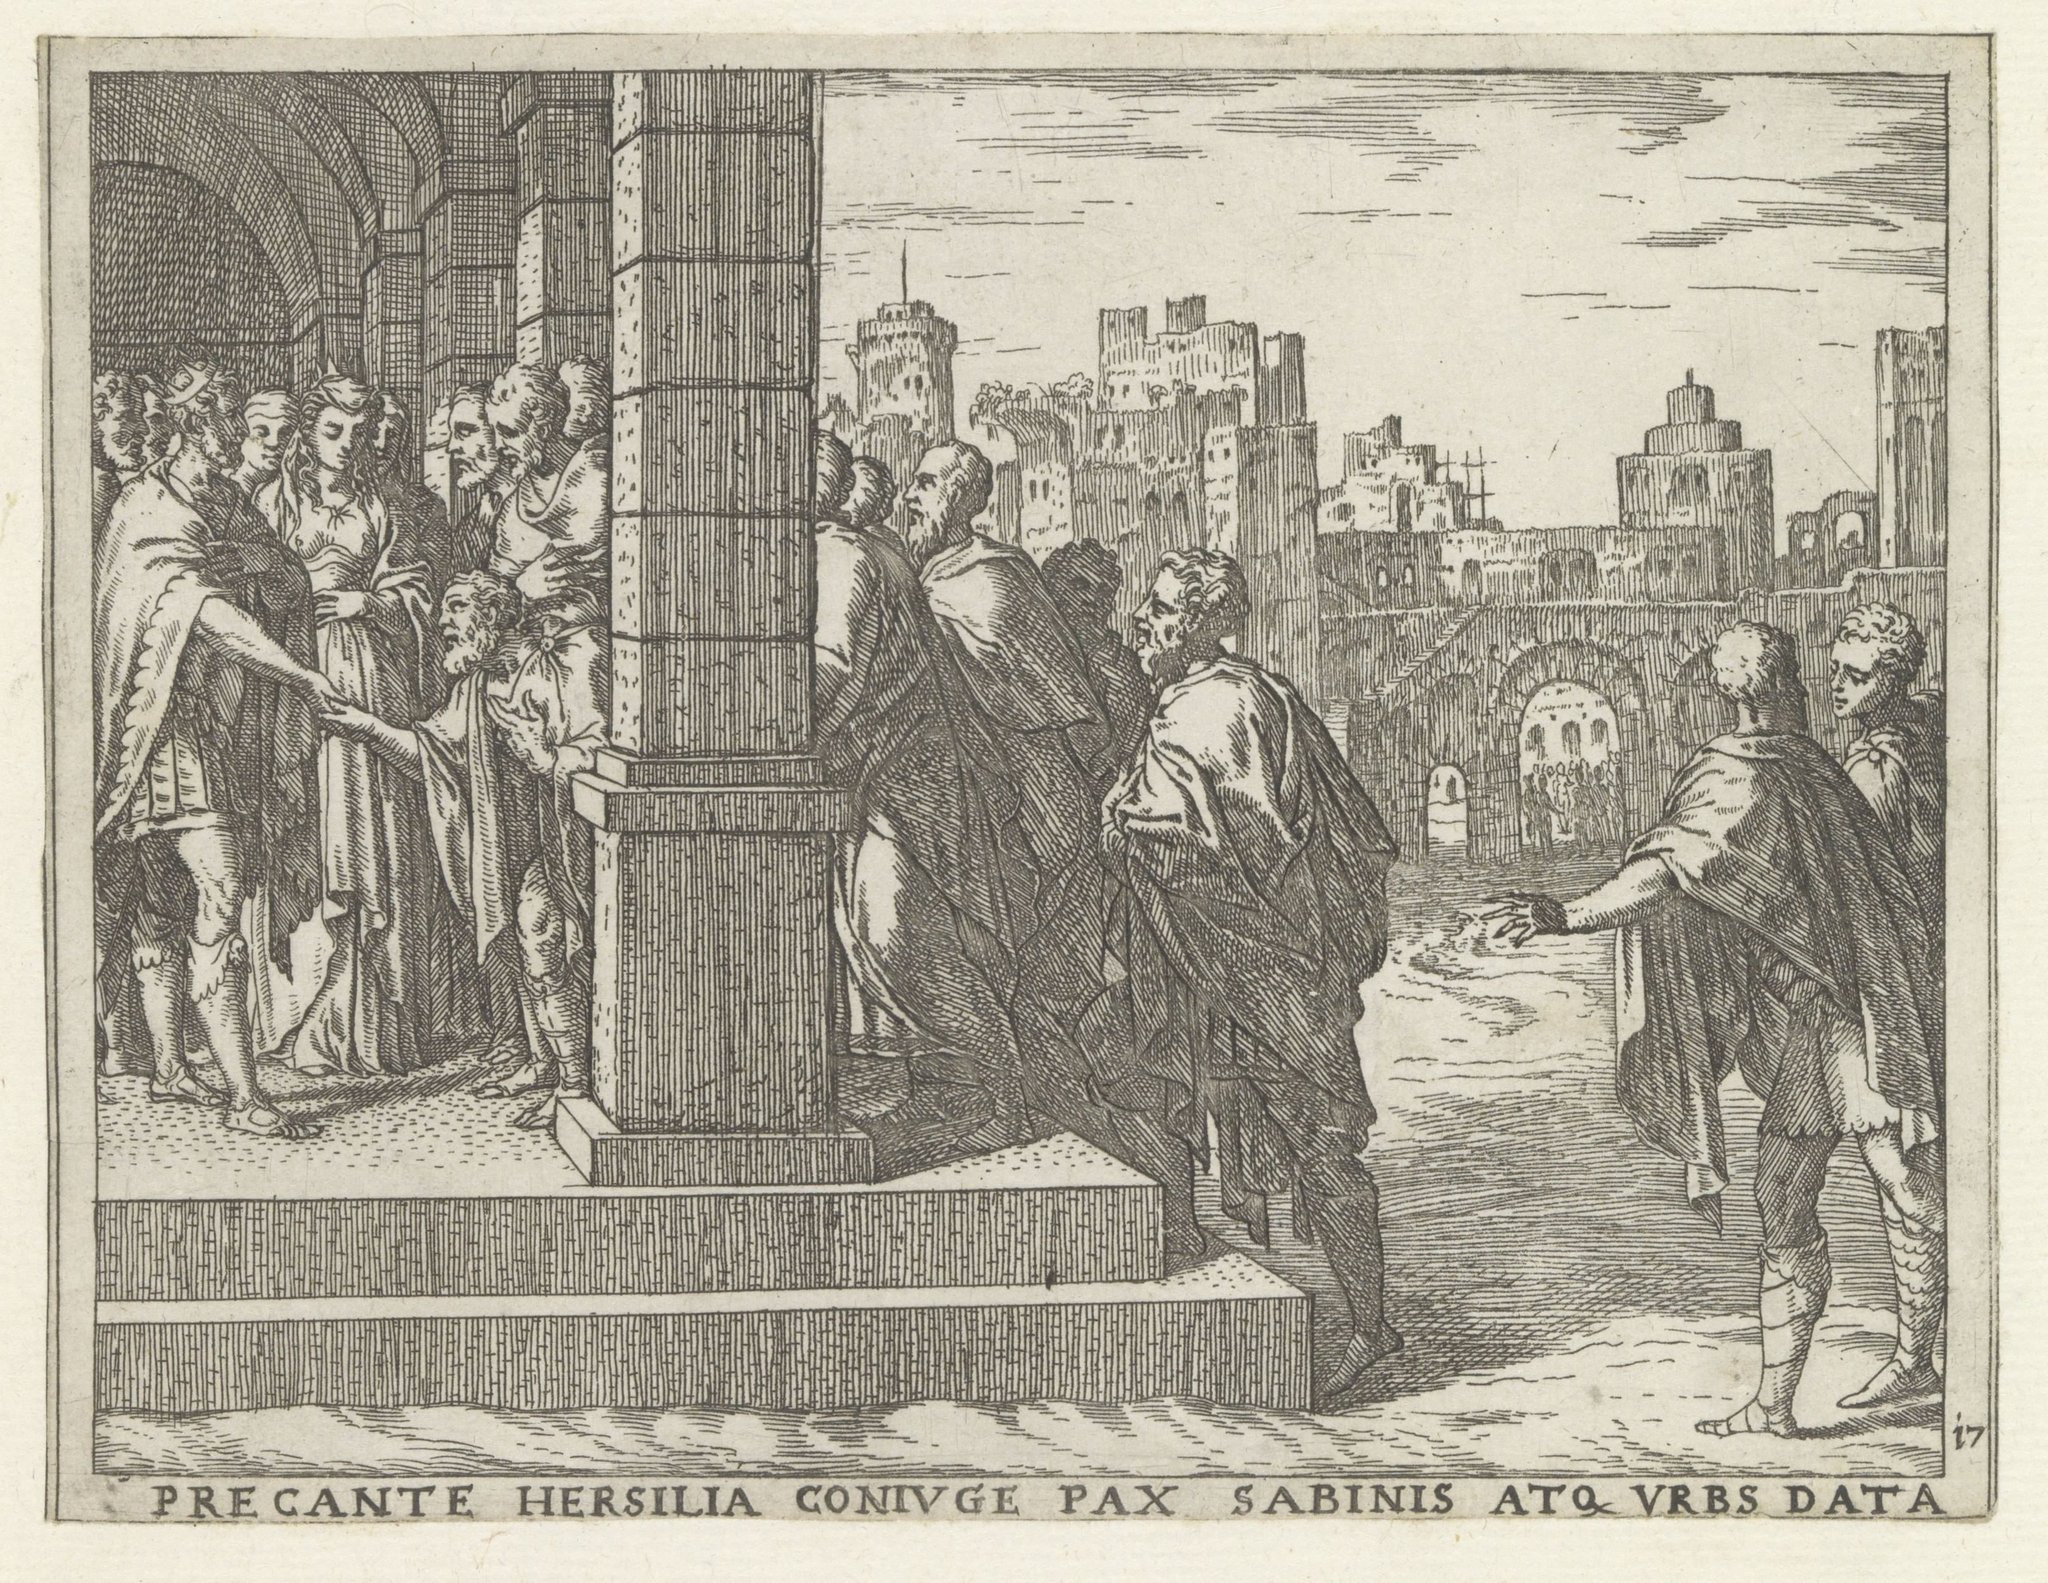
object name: album leaf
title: Leven van Romulus en Remus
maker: giovanni battista fontana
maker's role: draughtsman, painter, print maker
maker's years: 1524-1587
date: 1572-1573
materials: paper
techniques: etching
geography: italy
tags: (story of) romulus and remus, (story of) hersilia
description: Hersilia en Romulus staan onder een galerij. Verschillende mannen staan of knielen voor Romulus. De prent maakt deel uit van een album.